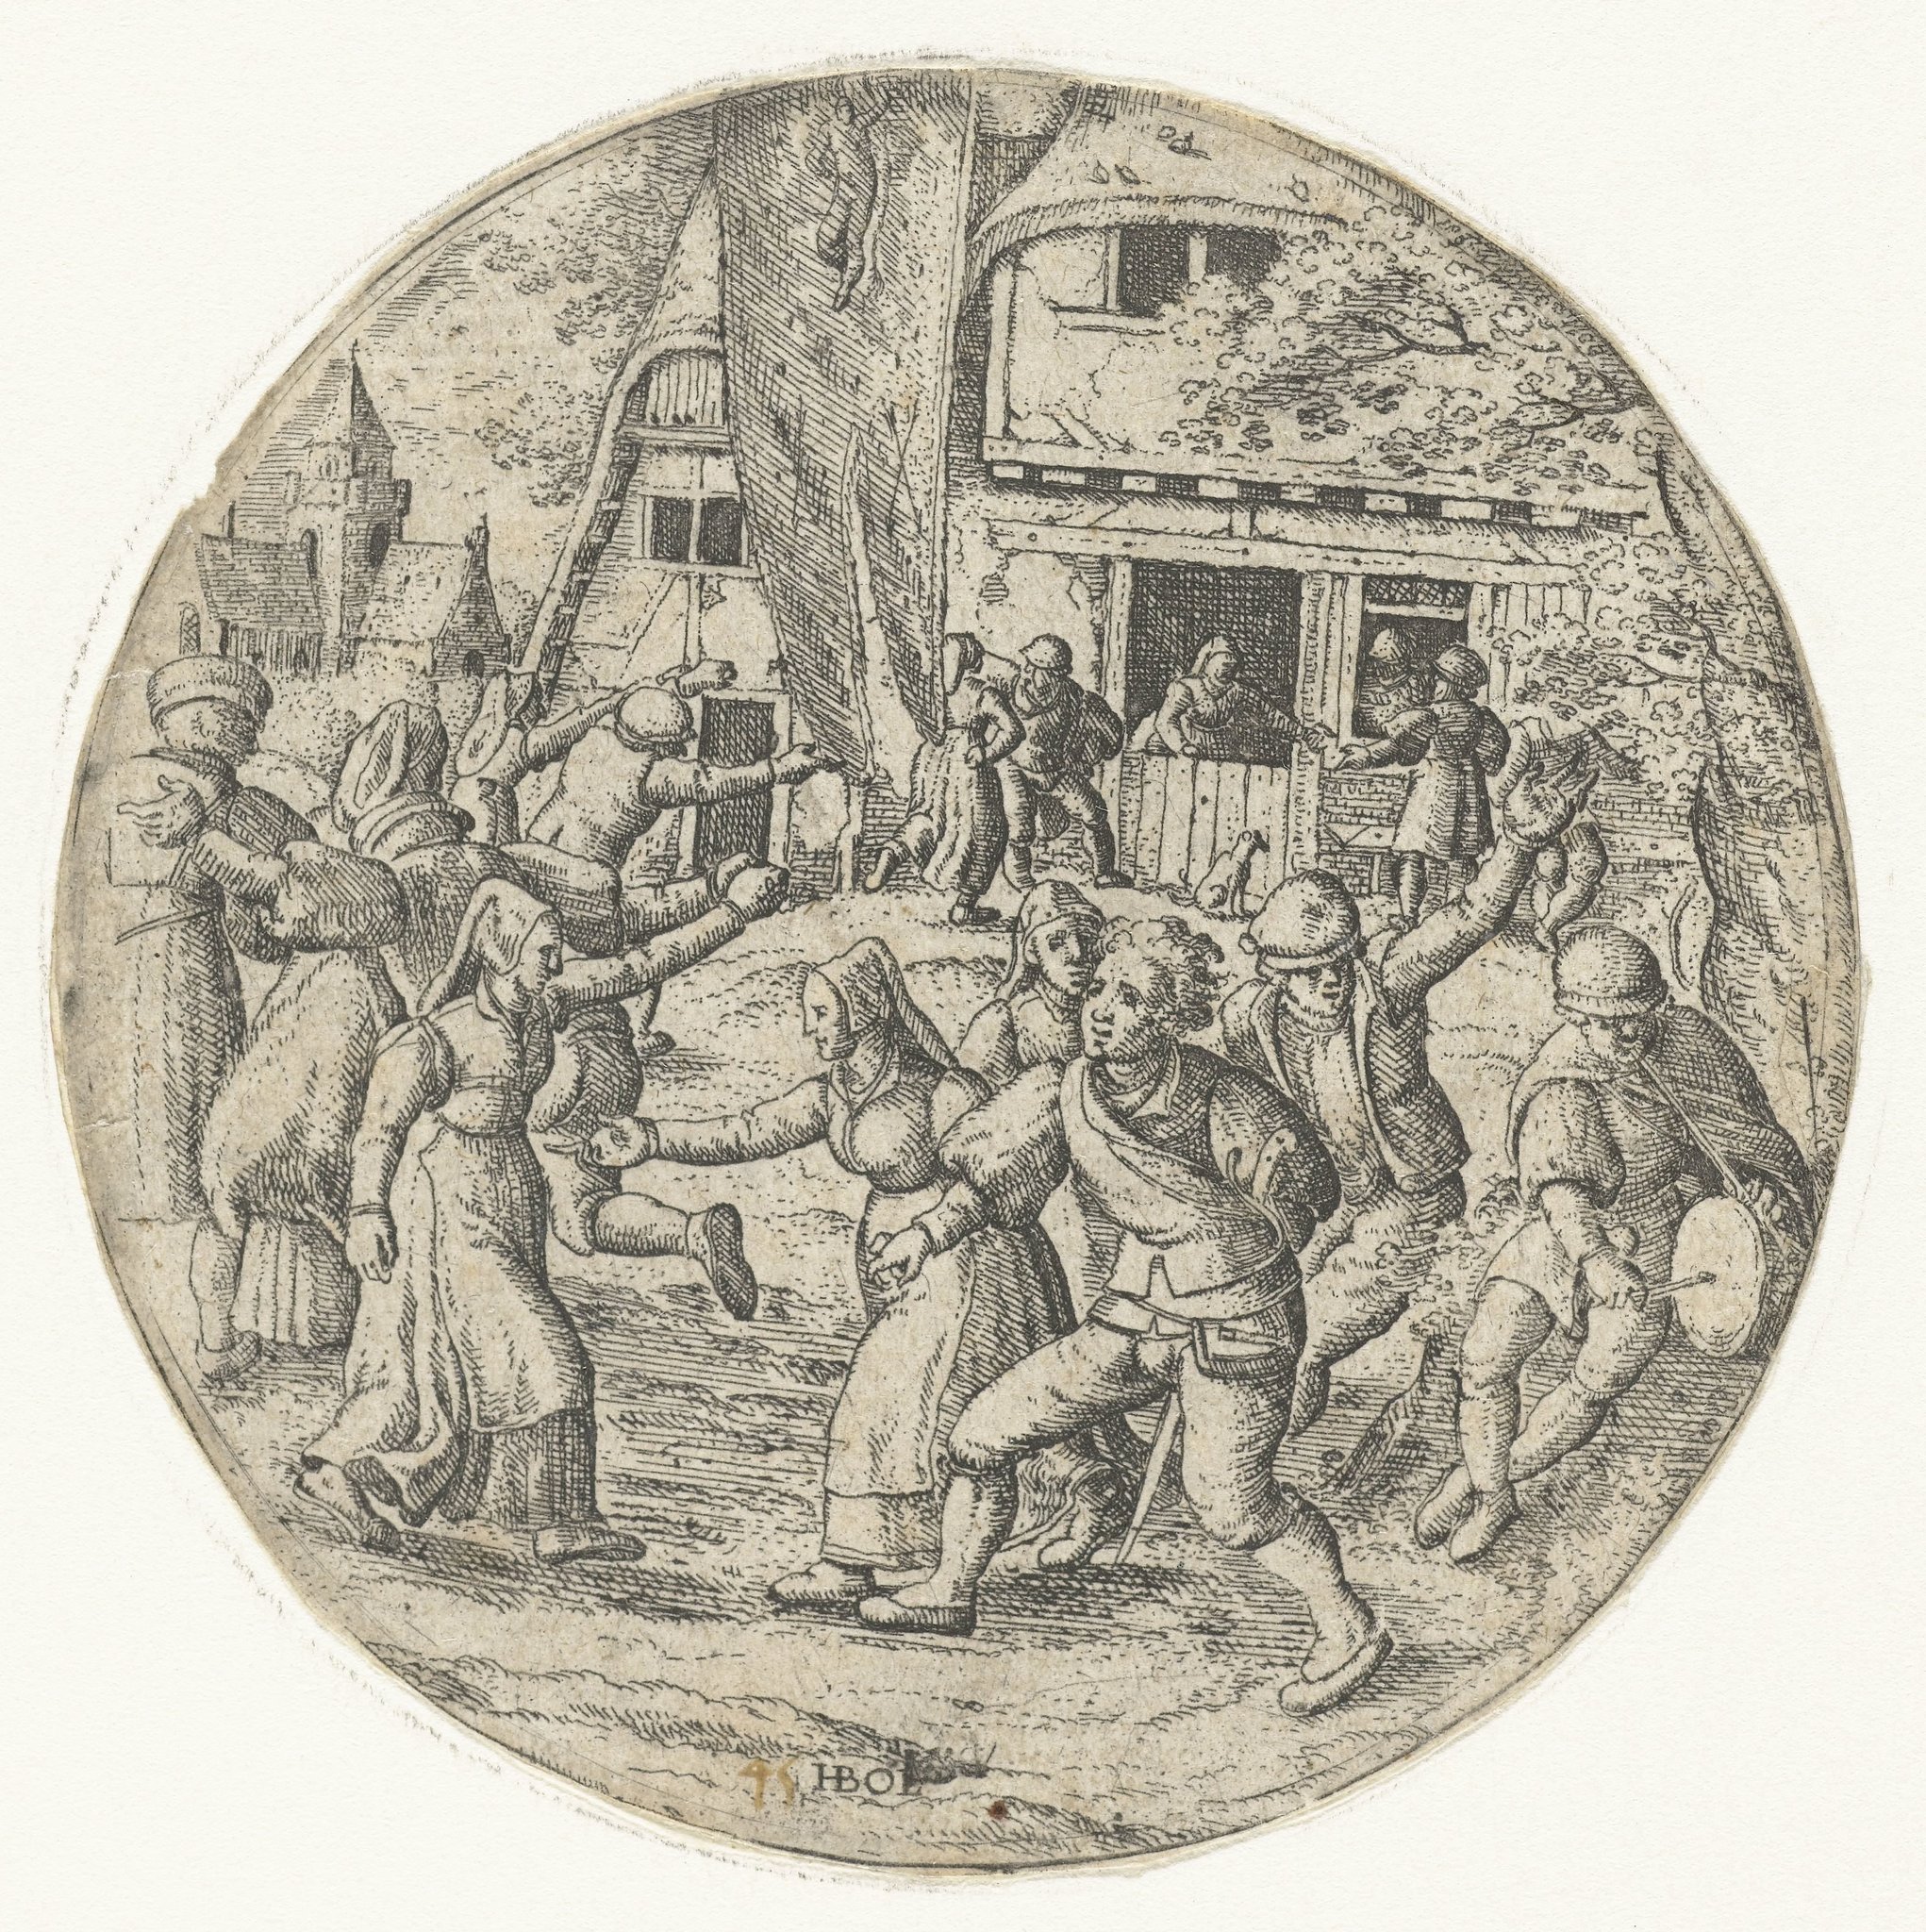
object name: print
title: Dansende boeren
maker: hans bol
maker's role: draughtsman, print maker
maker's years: 1534-1593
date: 1550-1593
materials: paper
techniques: etching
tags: festivities (+ dancing ~ festive activities)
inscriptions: collector's mark, collector's mark: Lugt 2228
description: Boeren dansen uitgelaten voor een boerderij. Een man onder een boom maakt muziek met een trommel.